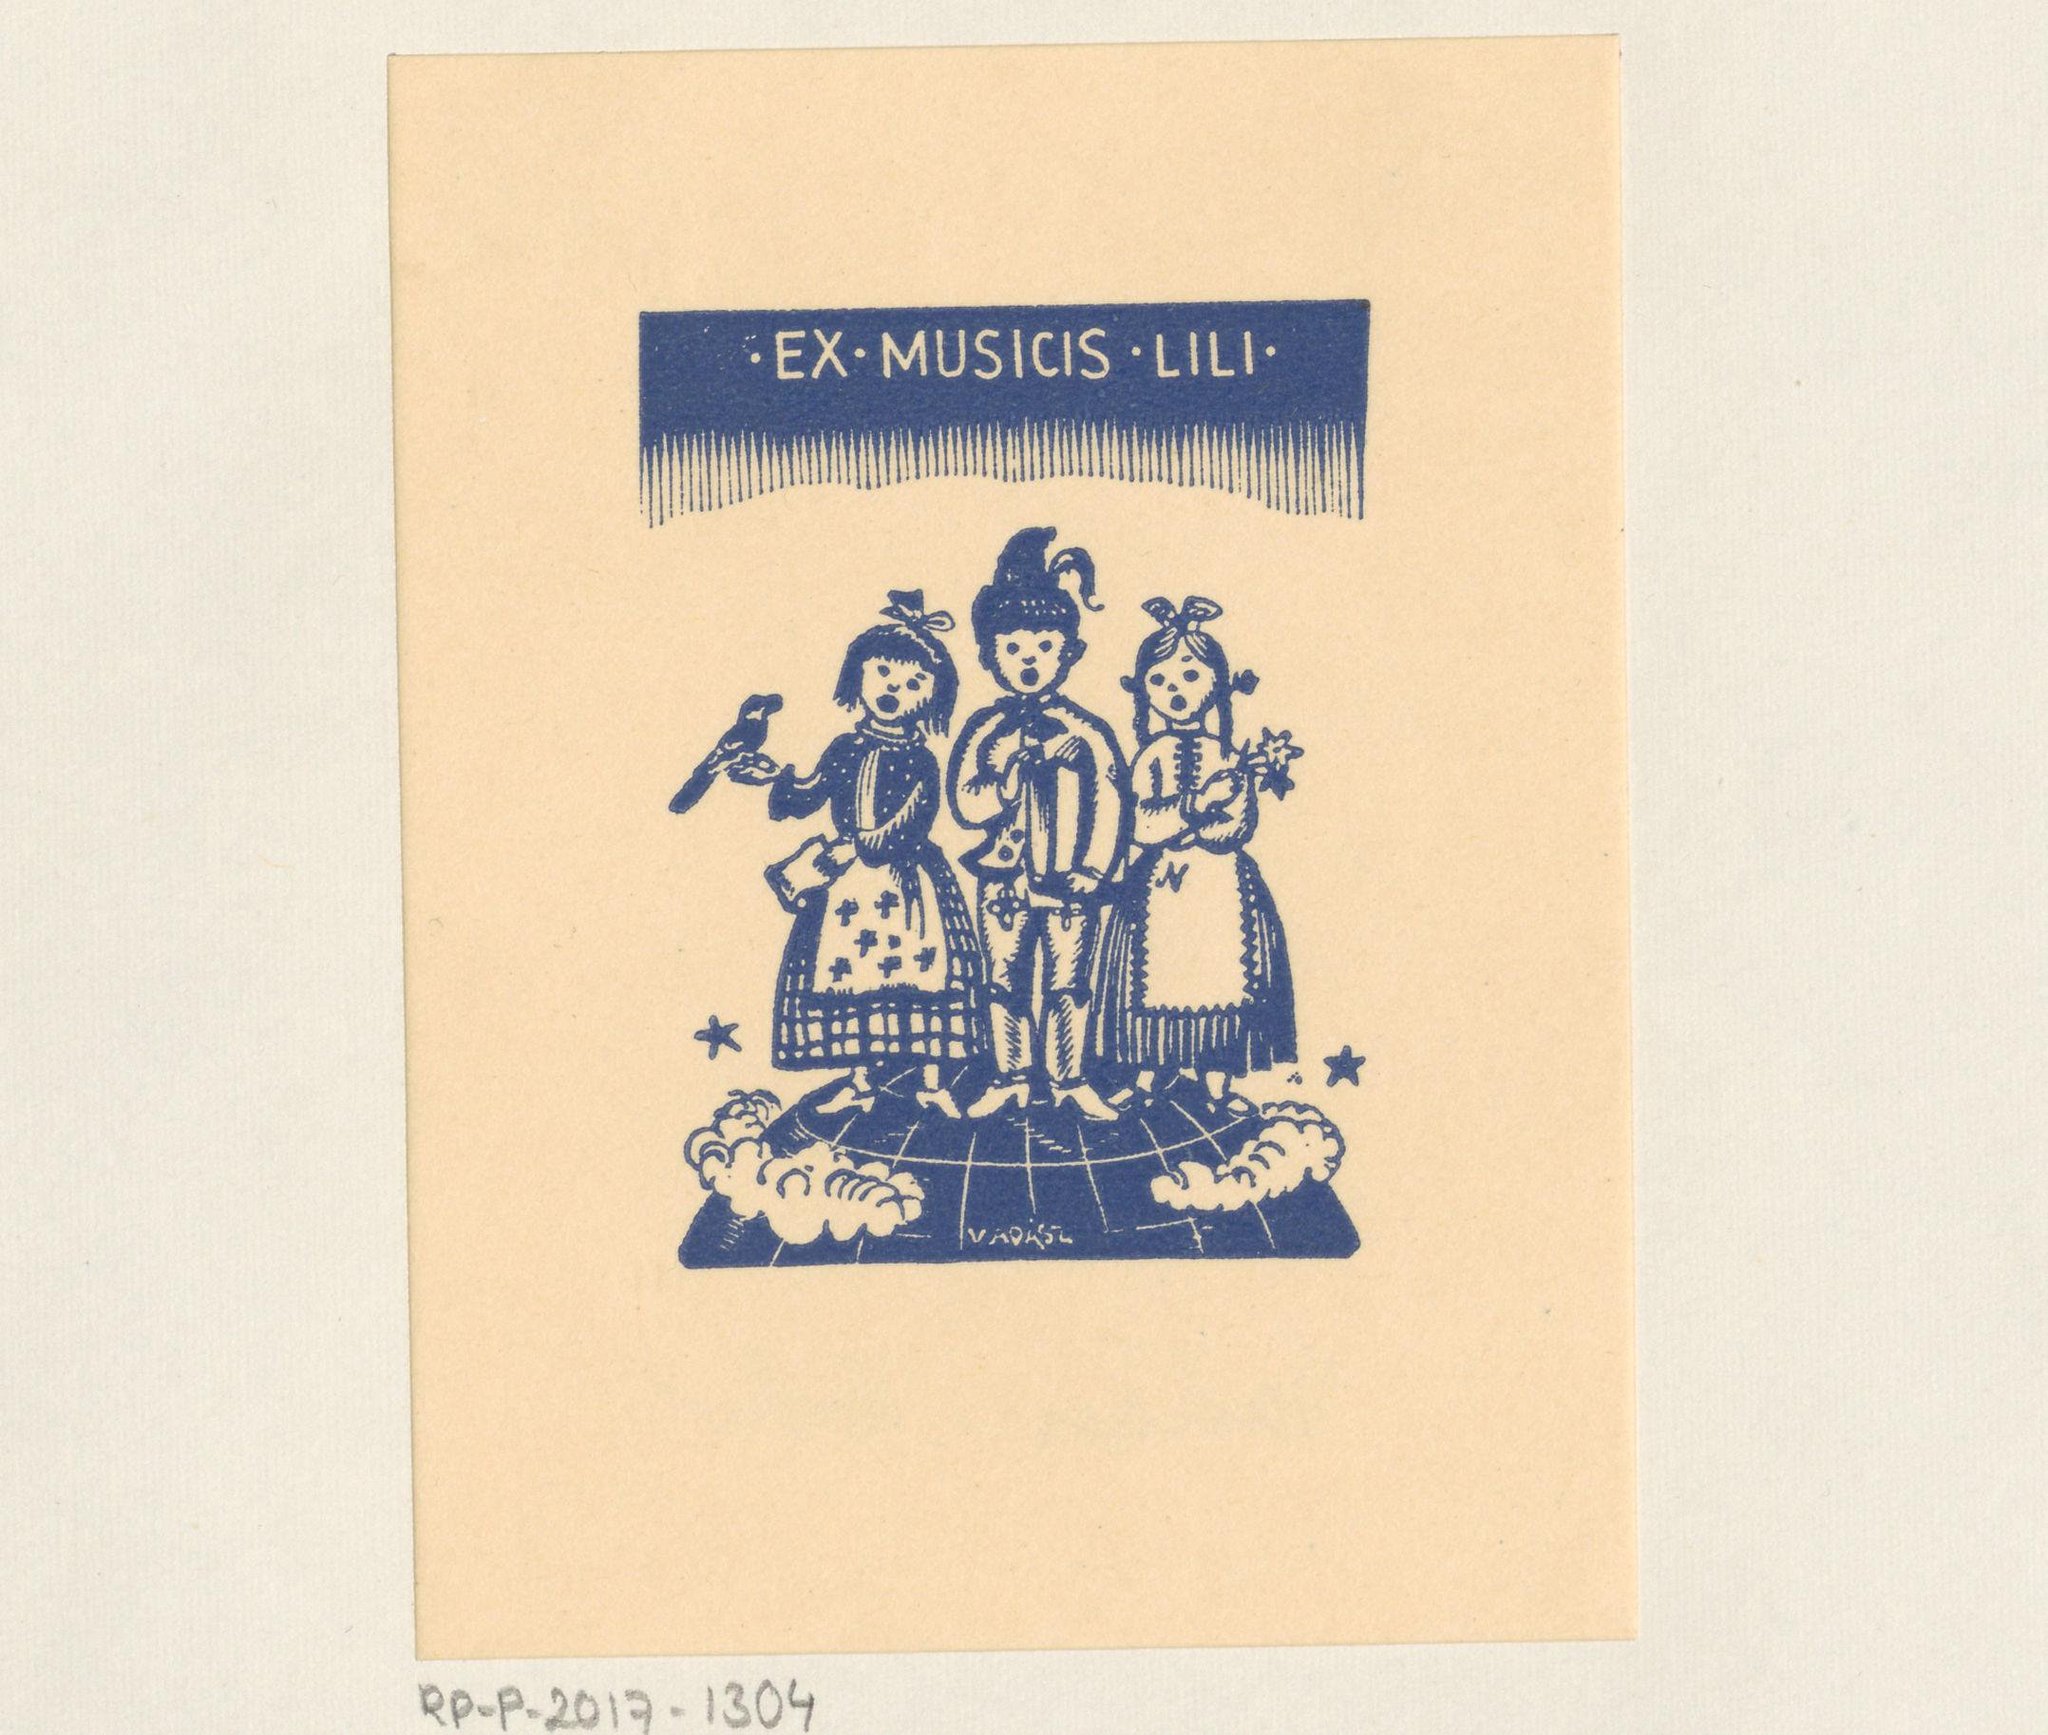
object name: bookplate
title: Ex libris van Lili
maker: endre vadász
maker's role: painter, print maker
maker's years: 1901-1944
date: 1911-1944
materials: paper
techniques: woodcut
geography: hungary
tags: boy (child between toddler and youth), girl (child between toddler and youth), folk costume, regional costume, children singing, globe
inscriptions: inscription: ‘Vadász - Holz’